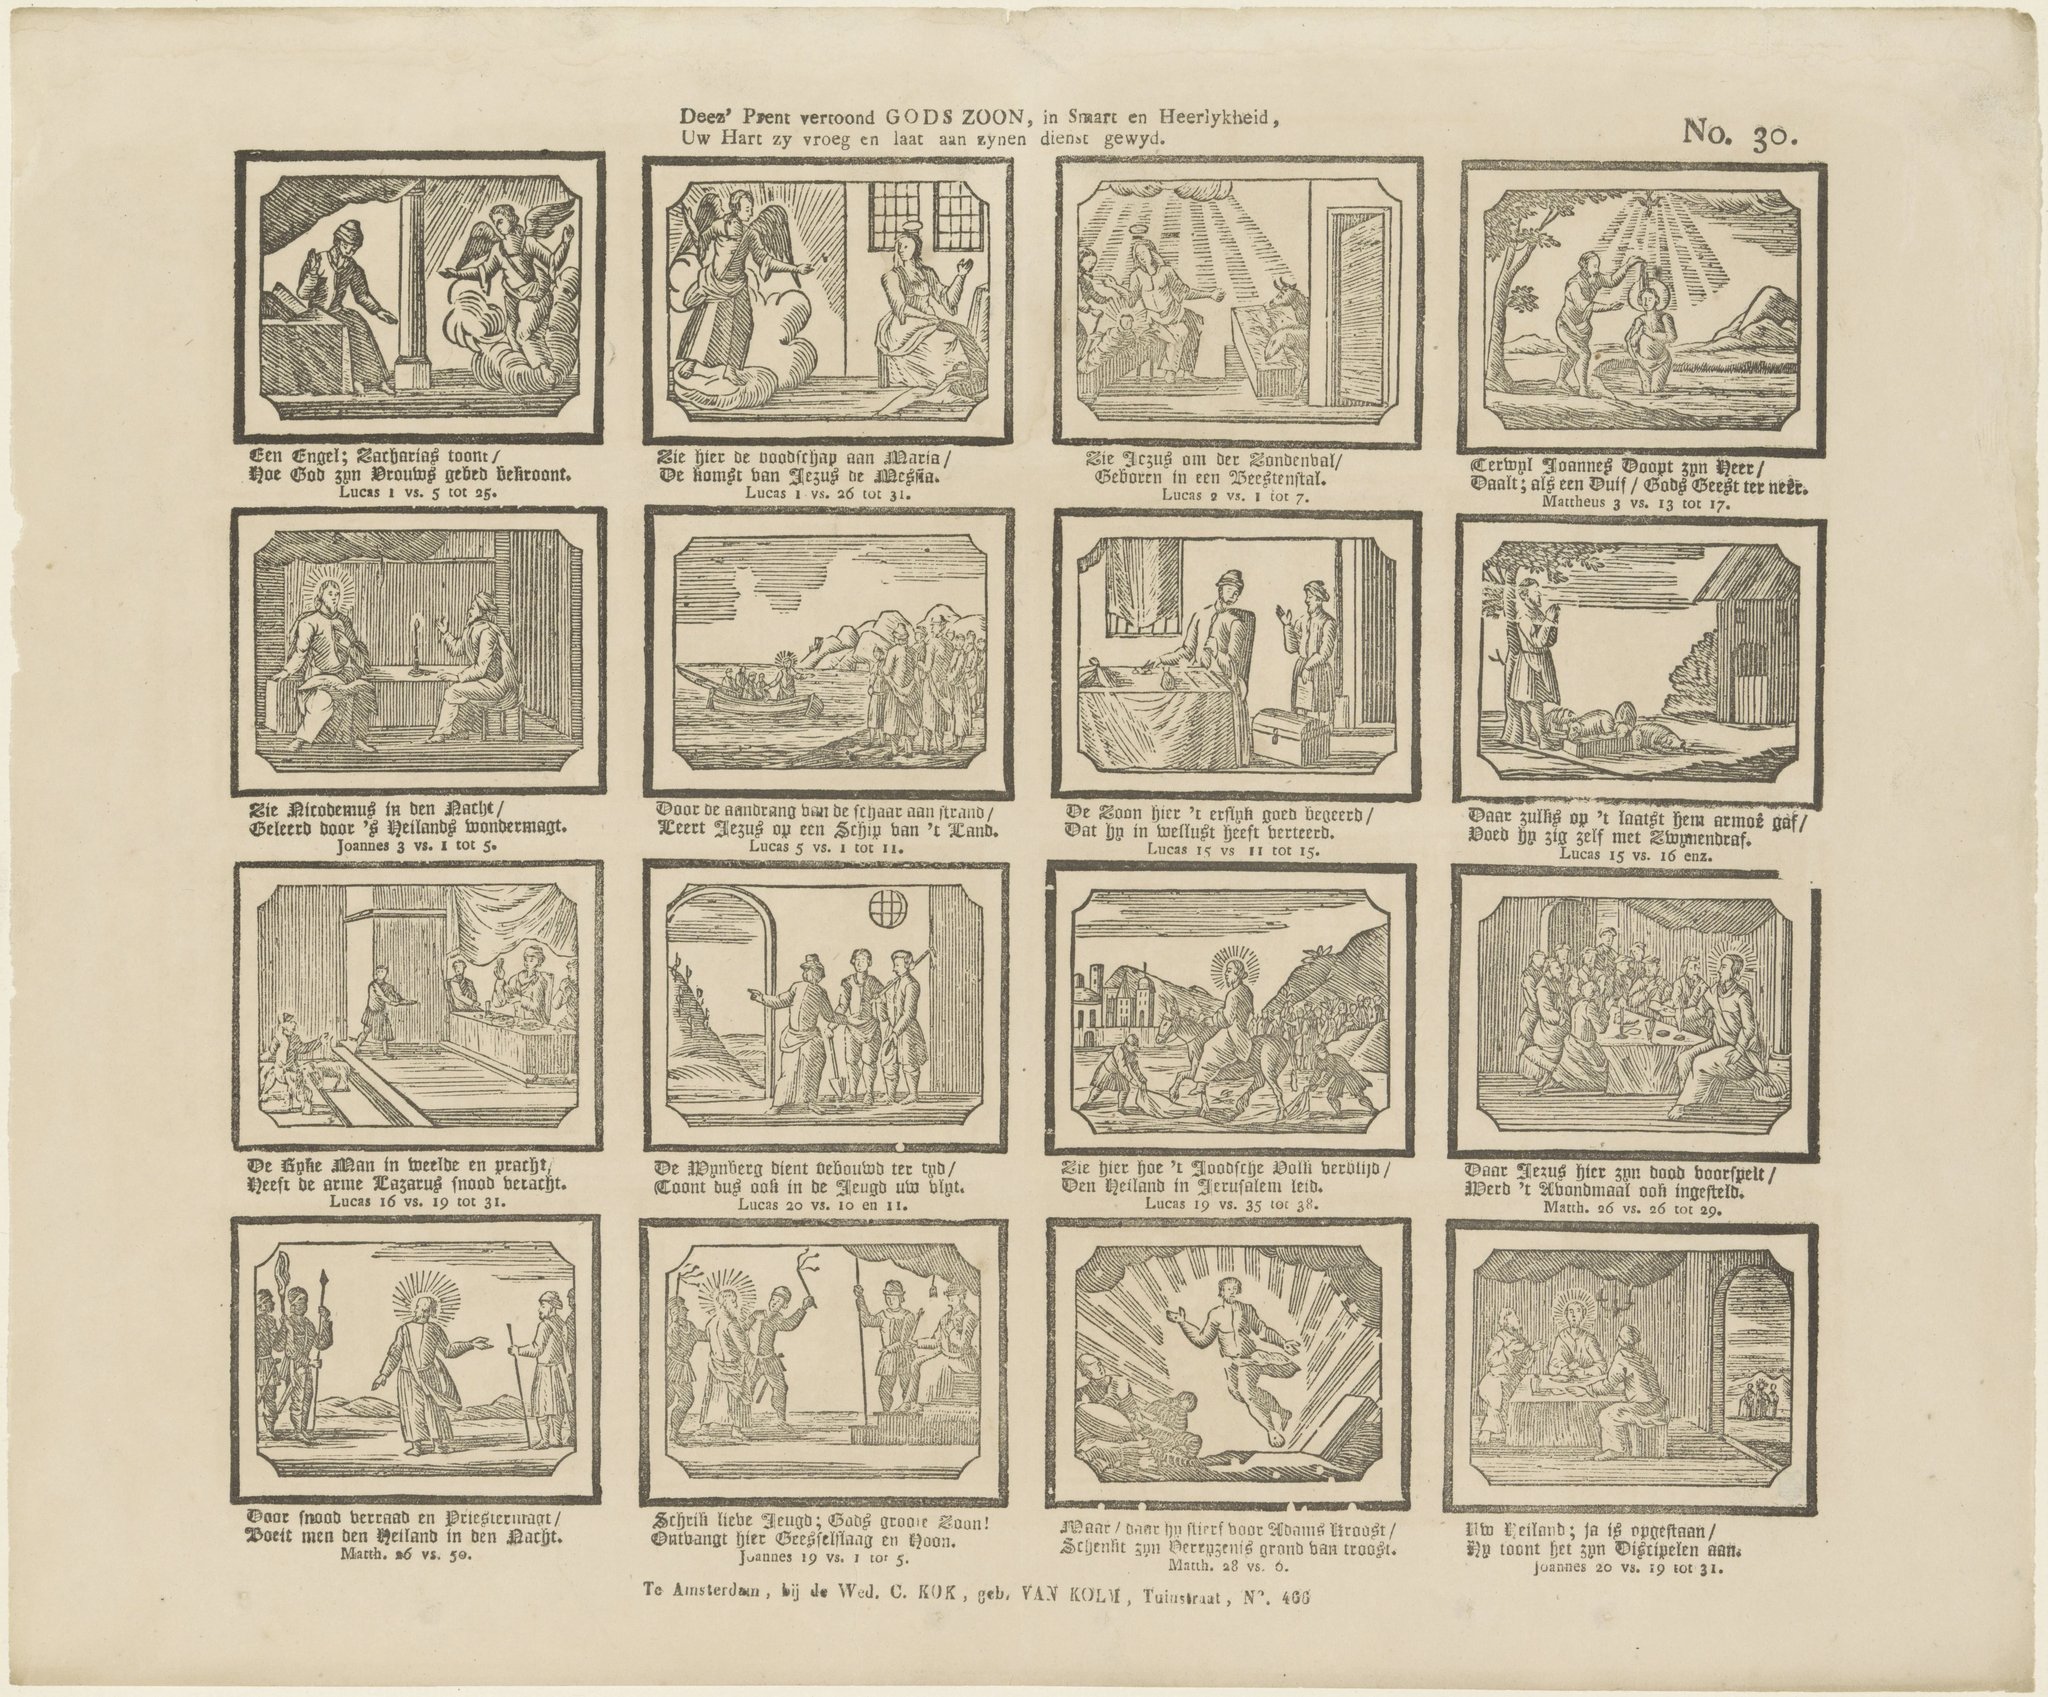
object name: popular print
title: Deez' prent vertoond Gods zoon, in snaart en heerlykheid, / Uw hart zy vroeg en laat aan zynen dienst gewyd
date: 1842-1866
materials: paper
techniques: letterpress printing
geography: amsterdam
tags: new testament, series of scenes from the life of christ, passion of christ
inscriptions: collector's mark: Lugt 2760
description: Blad met 16 voorstellingen over het leven van Jezus, waaronder de doop in de Jordaan, de intocht in Jeruzalem en de Geseling. Onder elke afbeelding een tweeregelig vers en bijbehorende Bijbelverwijzing. Genummerd rechtsboven: No. 30.